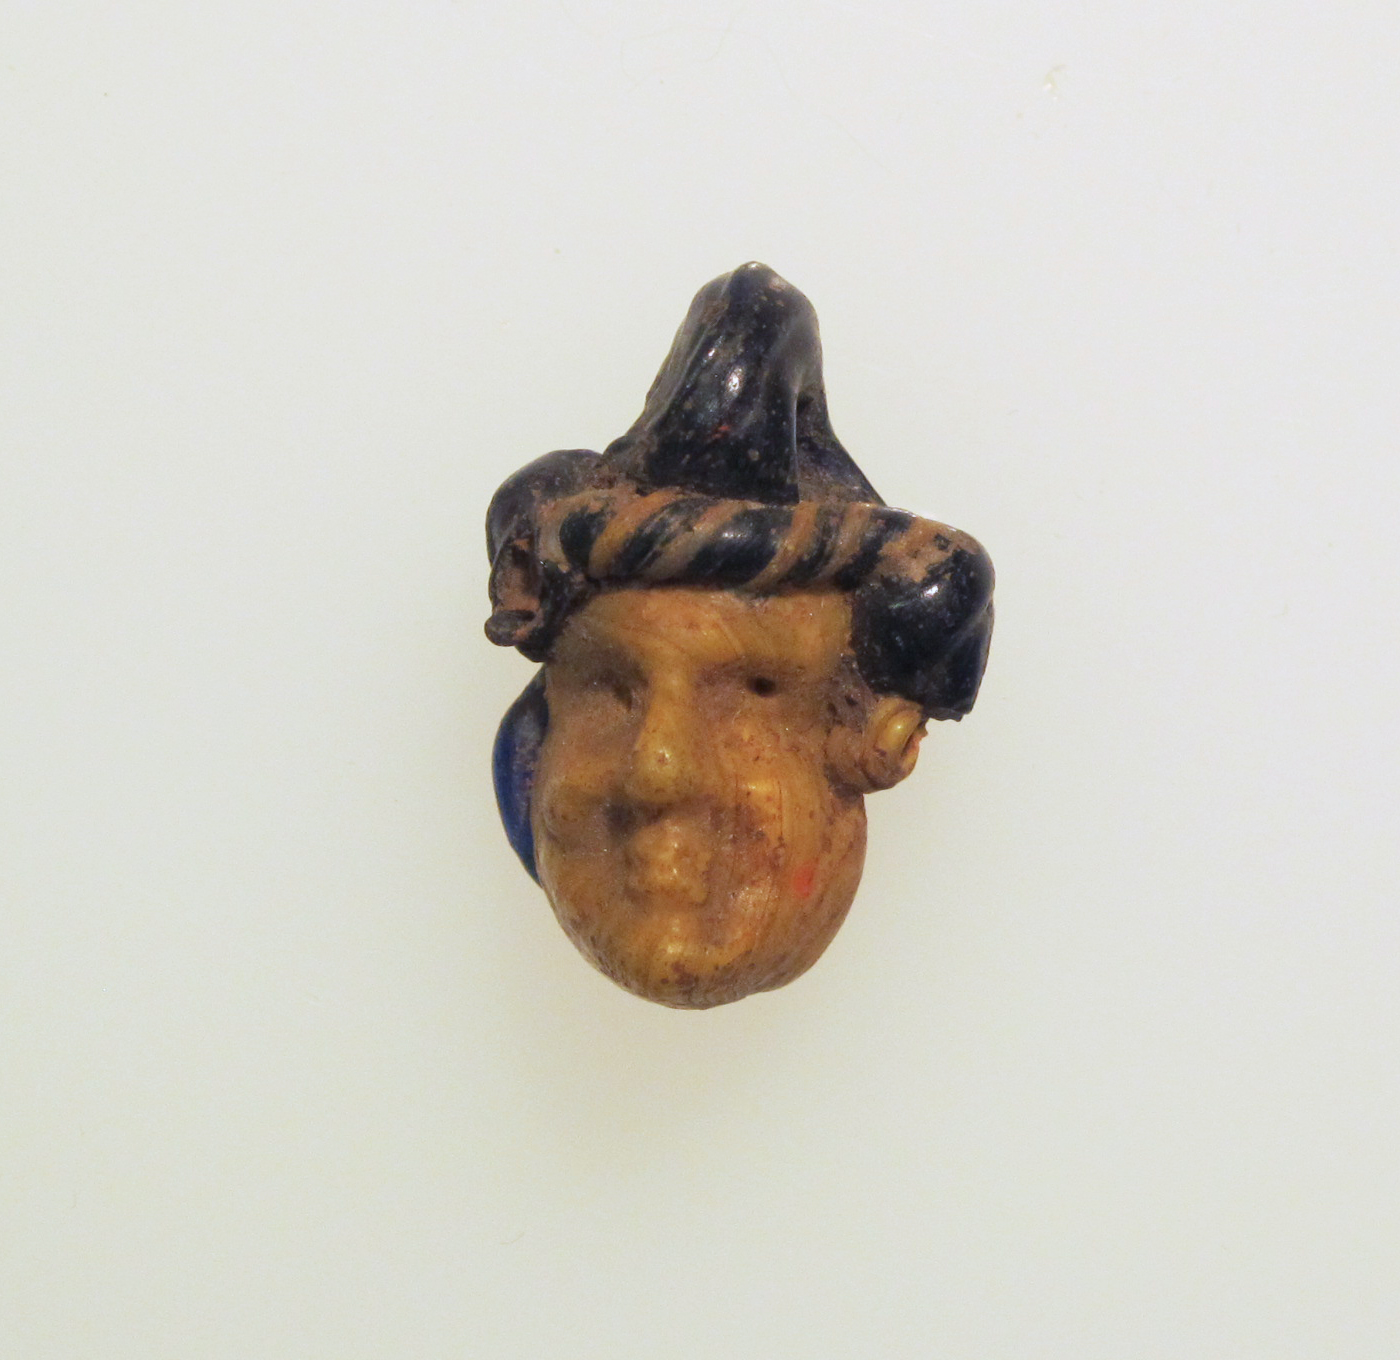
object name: head pendant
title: Glass head pendant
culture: carthaginian or eastern mediterranean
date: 300-1 BCE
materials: glass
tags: heads,men